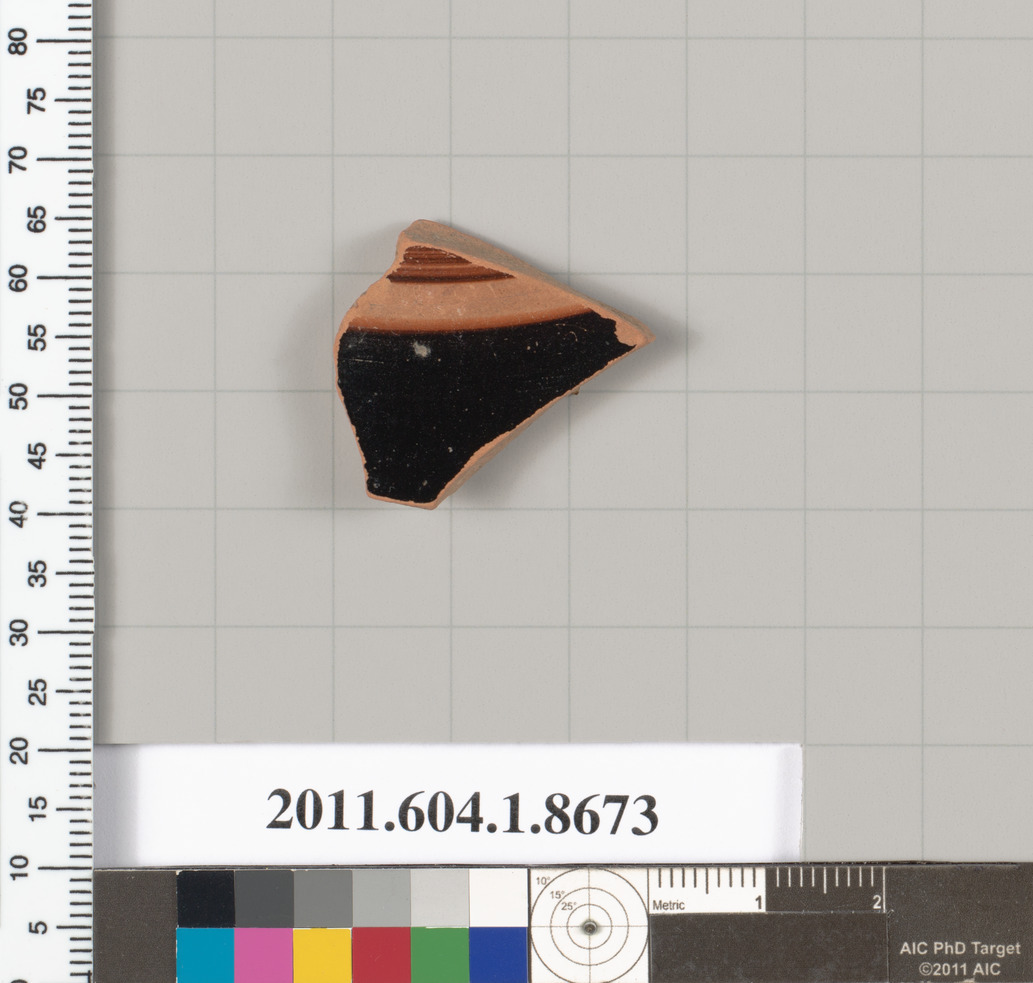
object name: kylix fragment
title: Terracotta fragment of a stemless kylix (drinking cup)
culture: greek, attic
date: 467-435 BCE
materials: terracotta